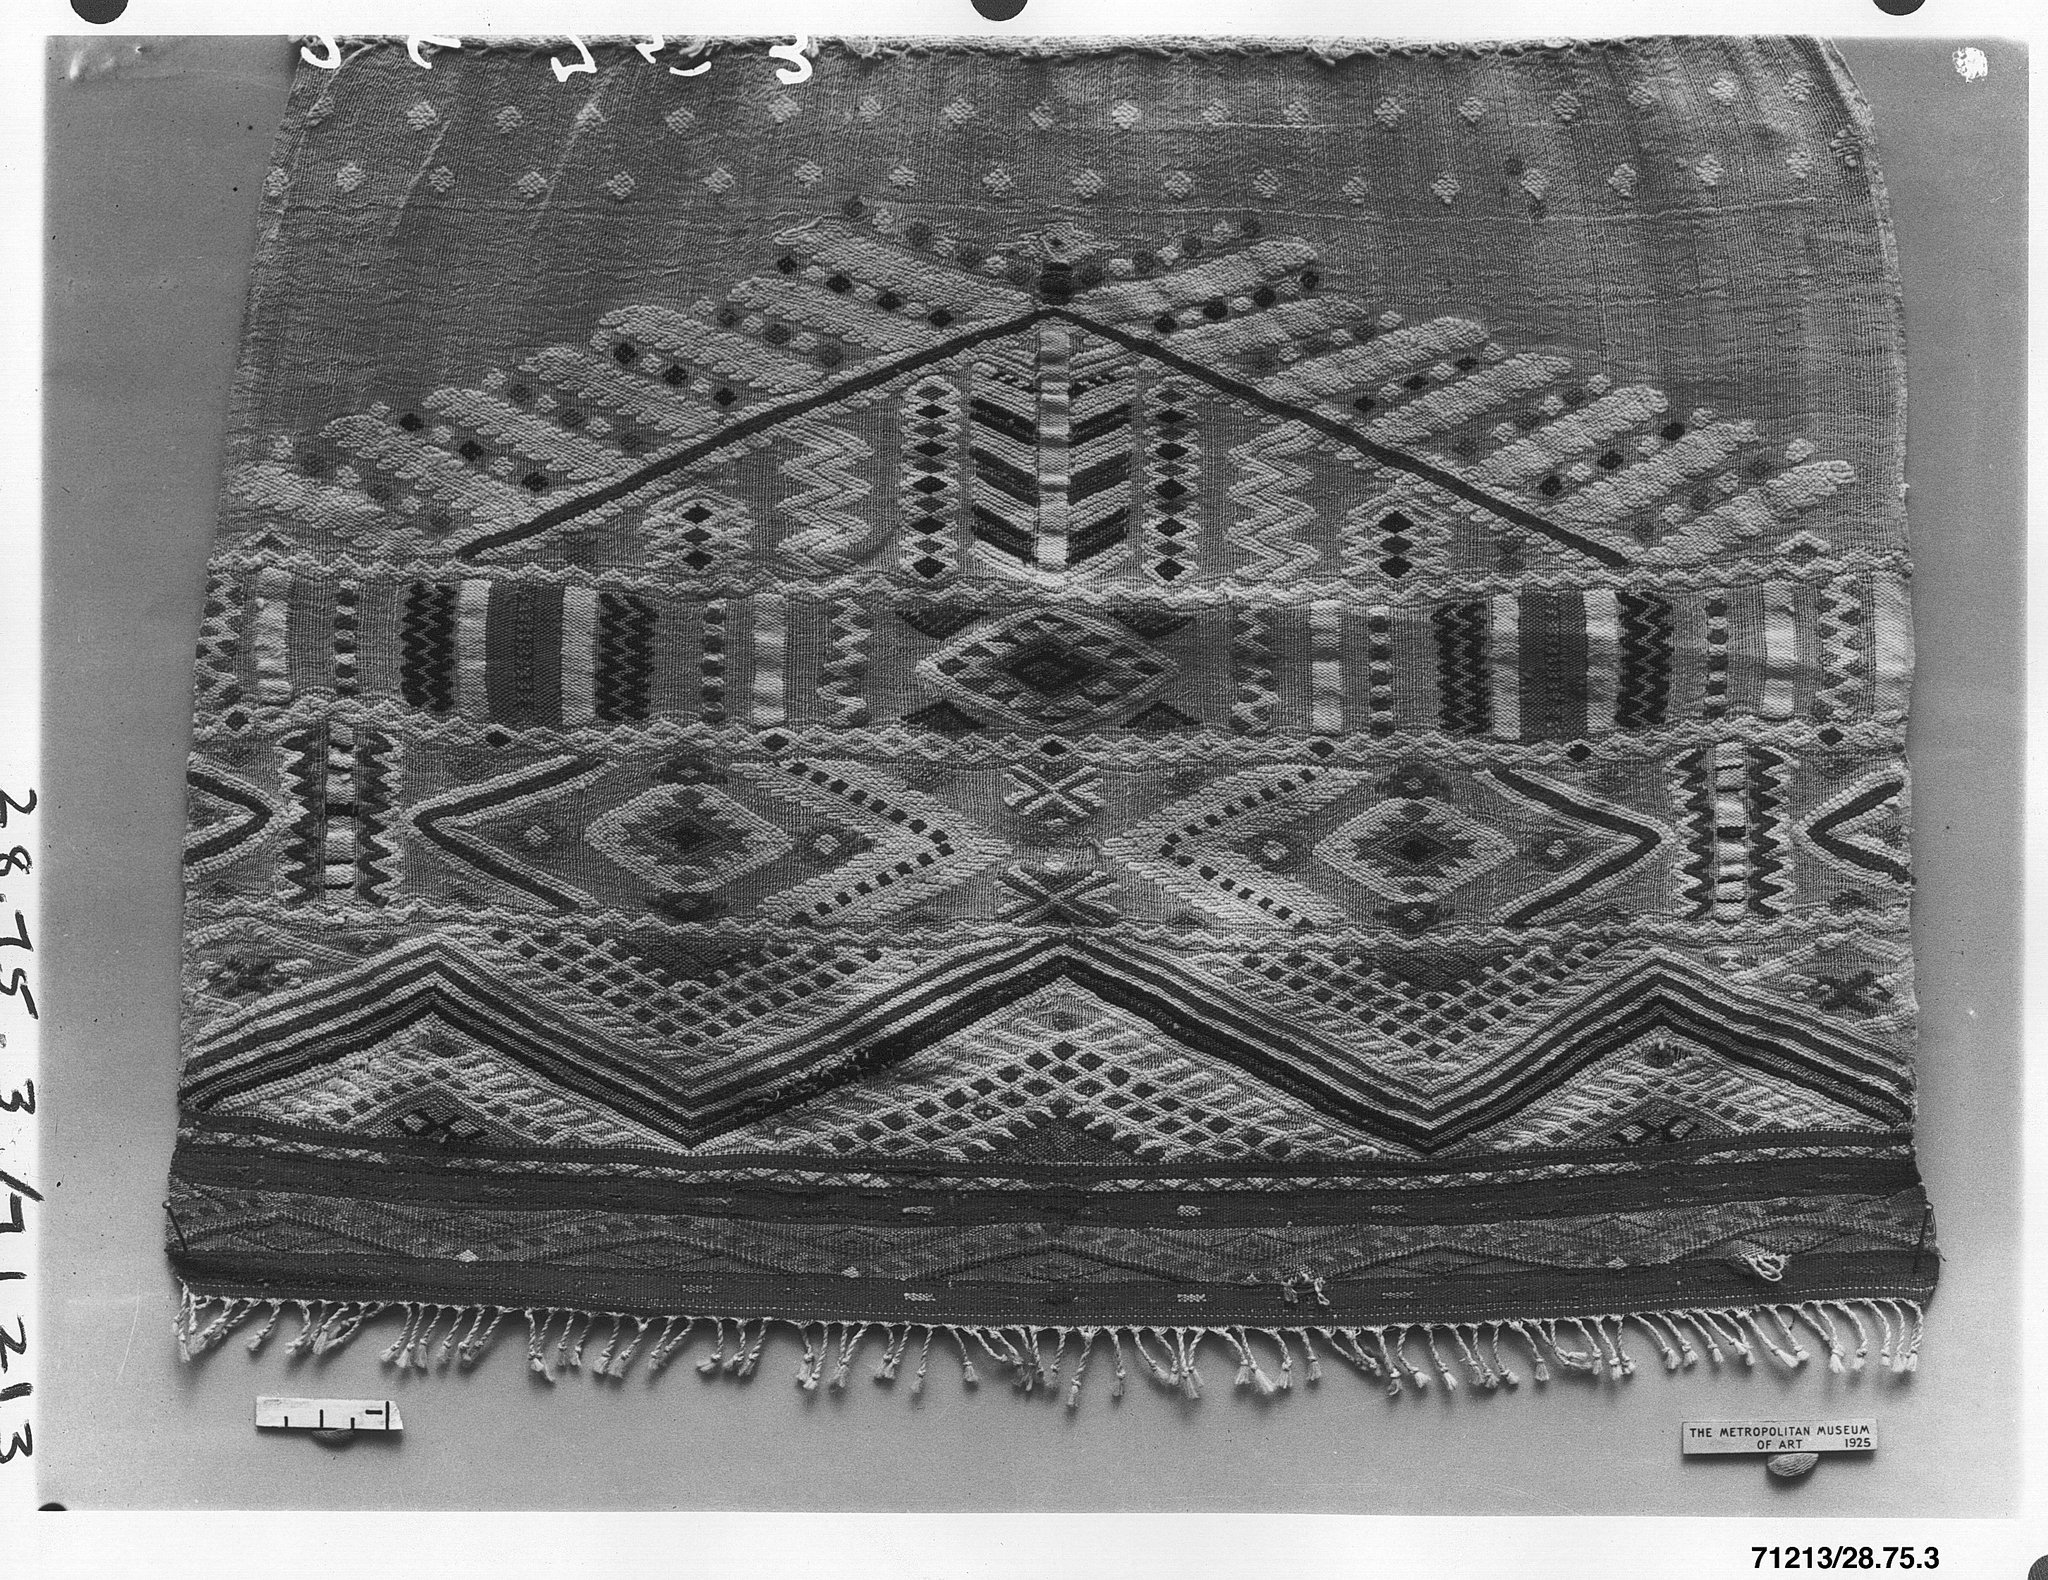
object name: towel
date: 1801-1833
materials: cotton, linen, metal thread